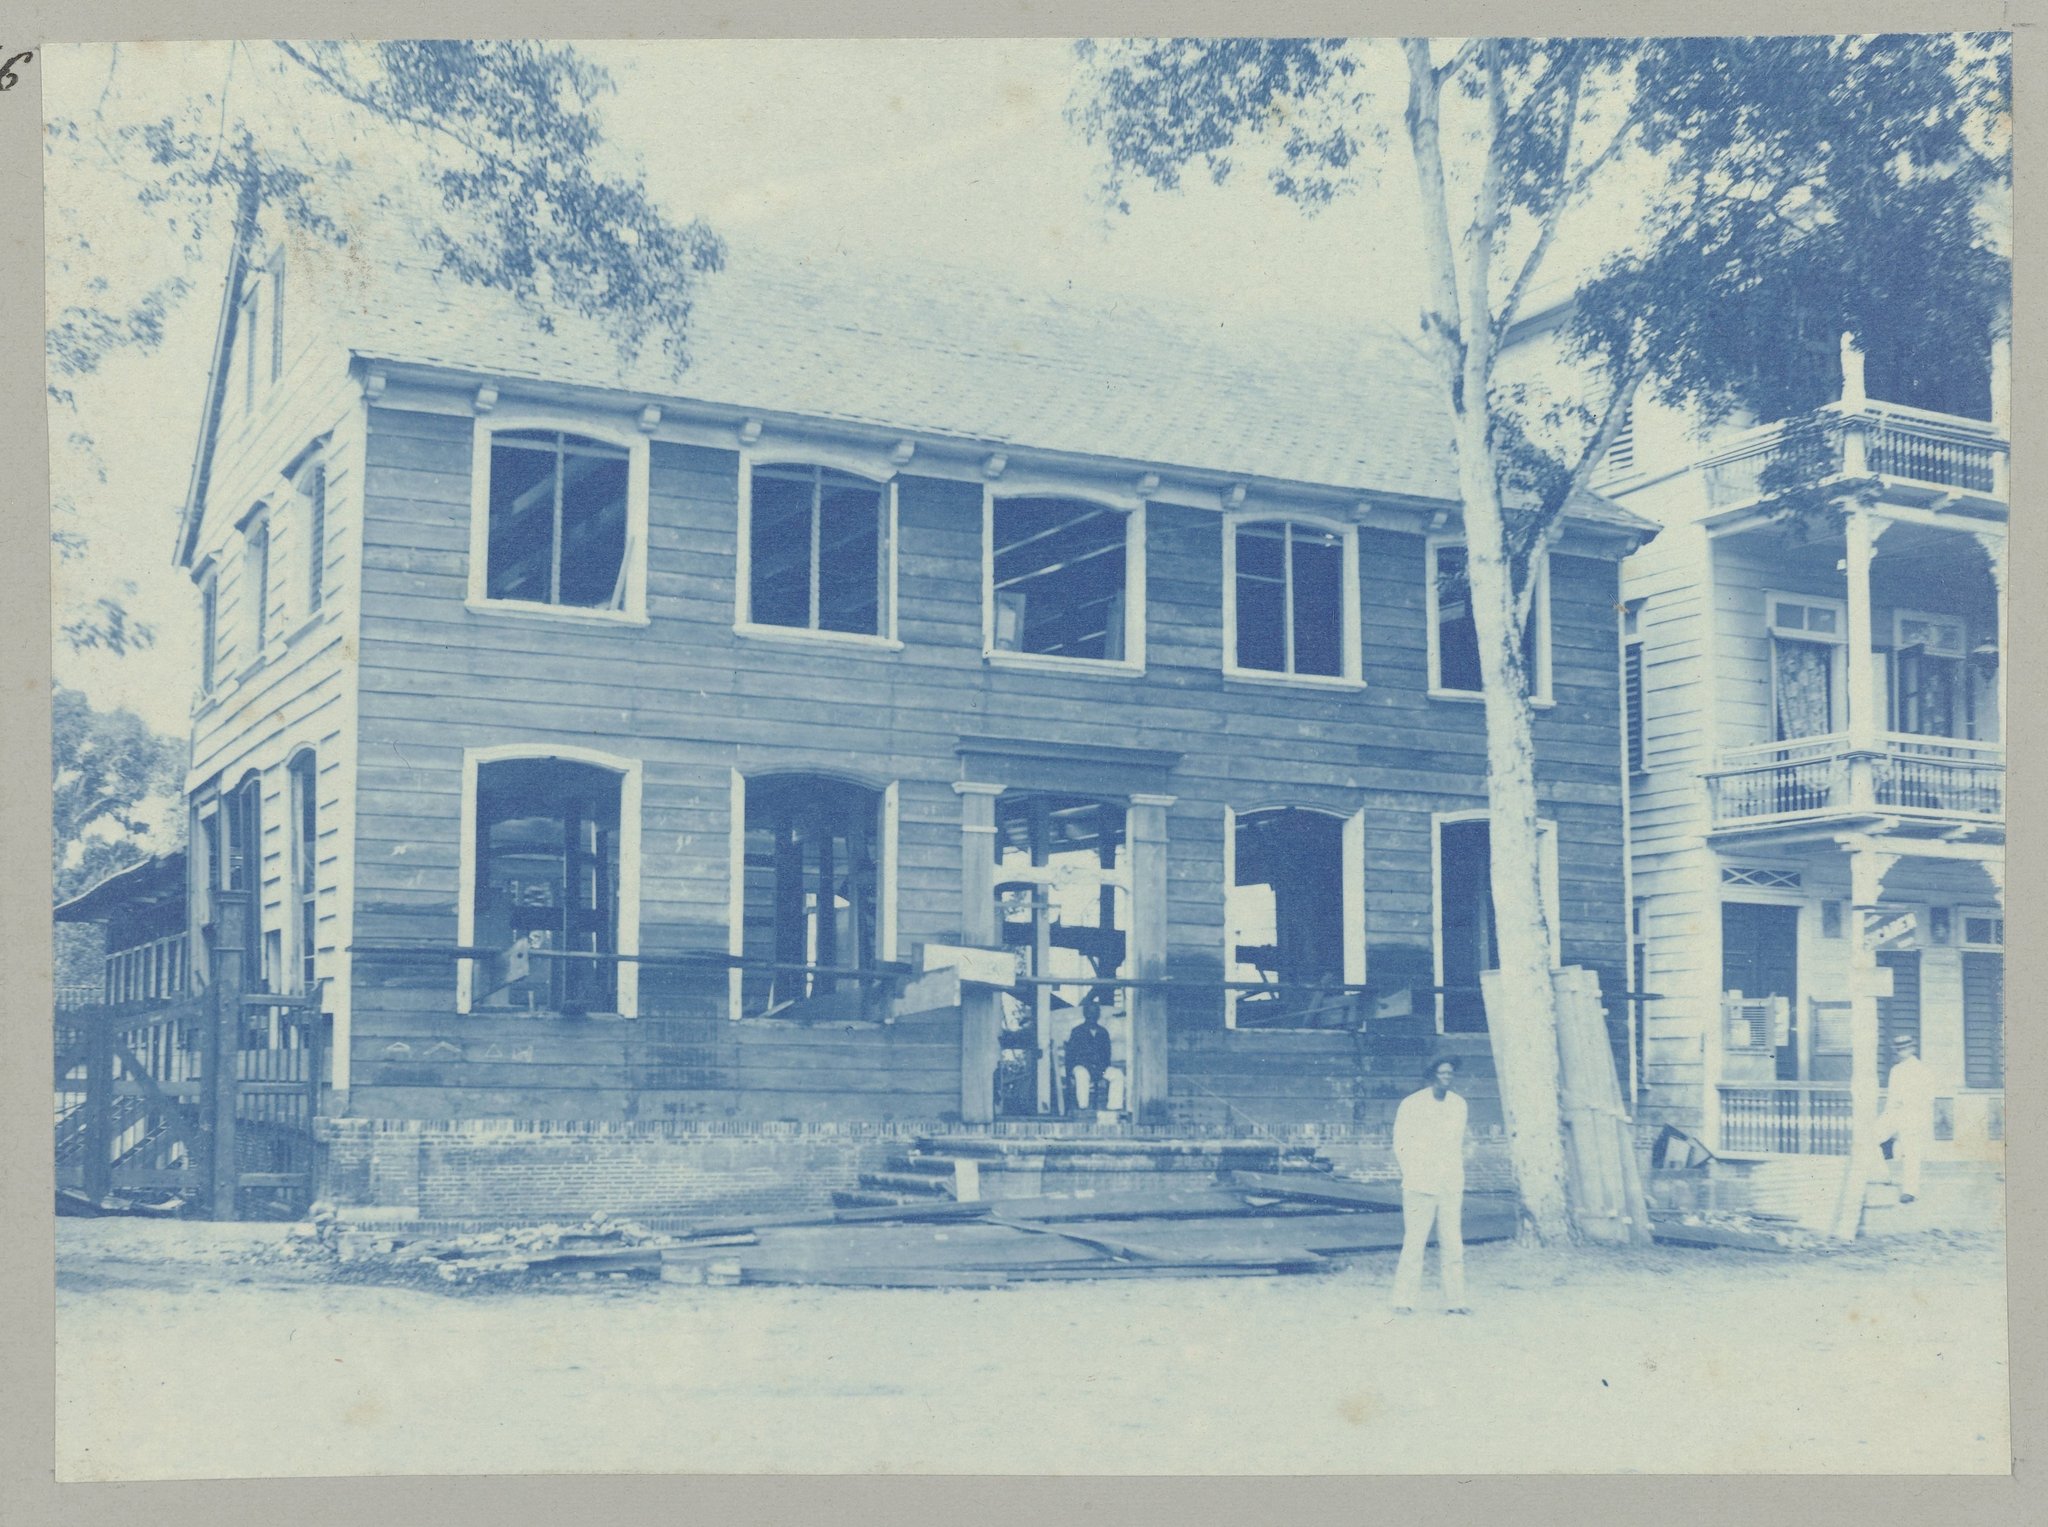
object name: photograph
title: Emmaschool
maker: hendrik doijer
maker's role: engineer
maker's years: 1863-1925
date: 1903-1910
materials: photographic support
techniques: cyanotype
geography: suriname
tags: suriname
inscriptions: inscription: ‘E6 / Emmaschool.’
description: De Emmaschool te Paramaribo in aanbouw, gezicht vanaf de straat. Onderdeel van het fotoalbum Souvenir de Voyage (deel 4), over het leven van de familie Doijer in en rond de plantage Ma Retraite in Suriname in de jaren 1903-1910.